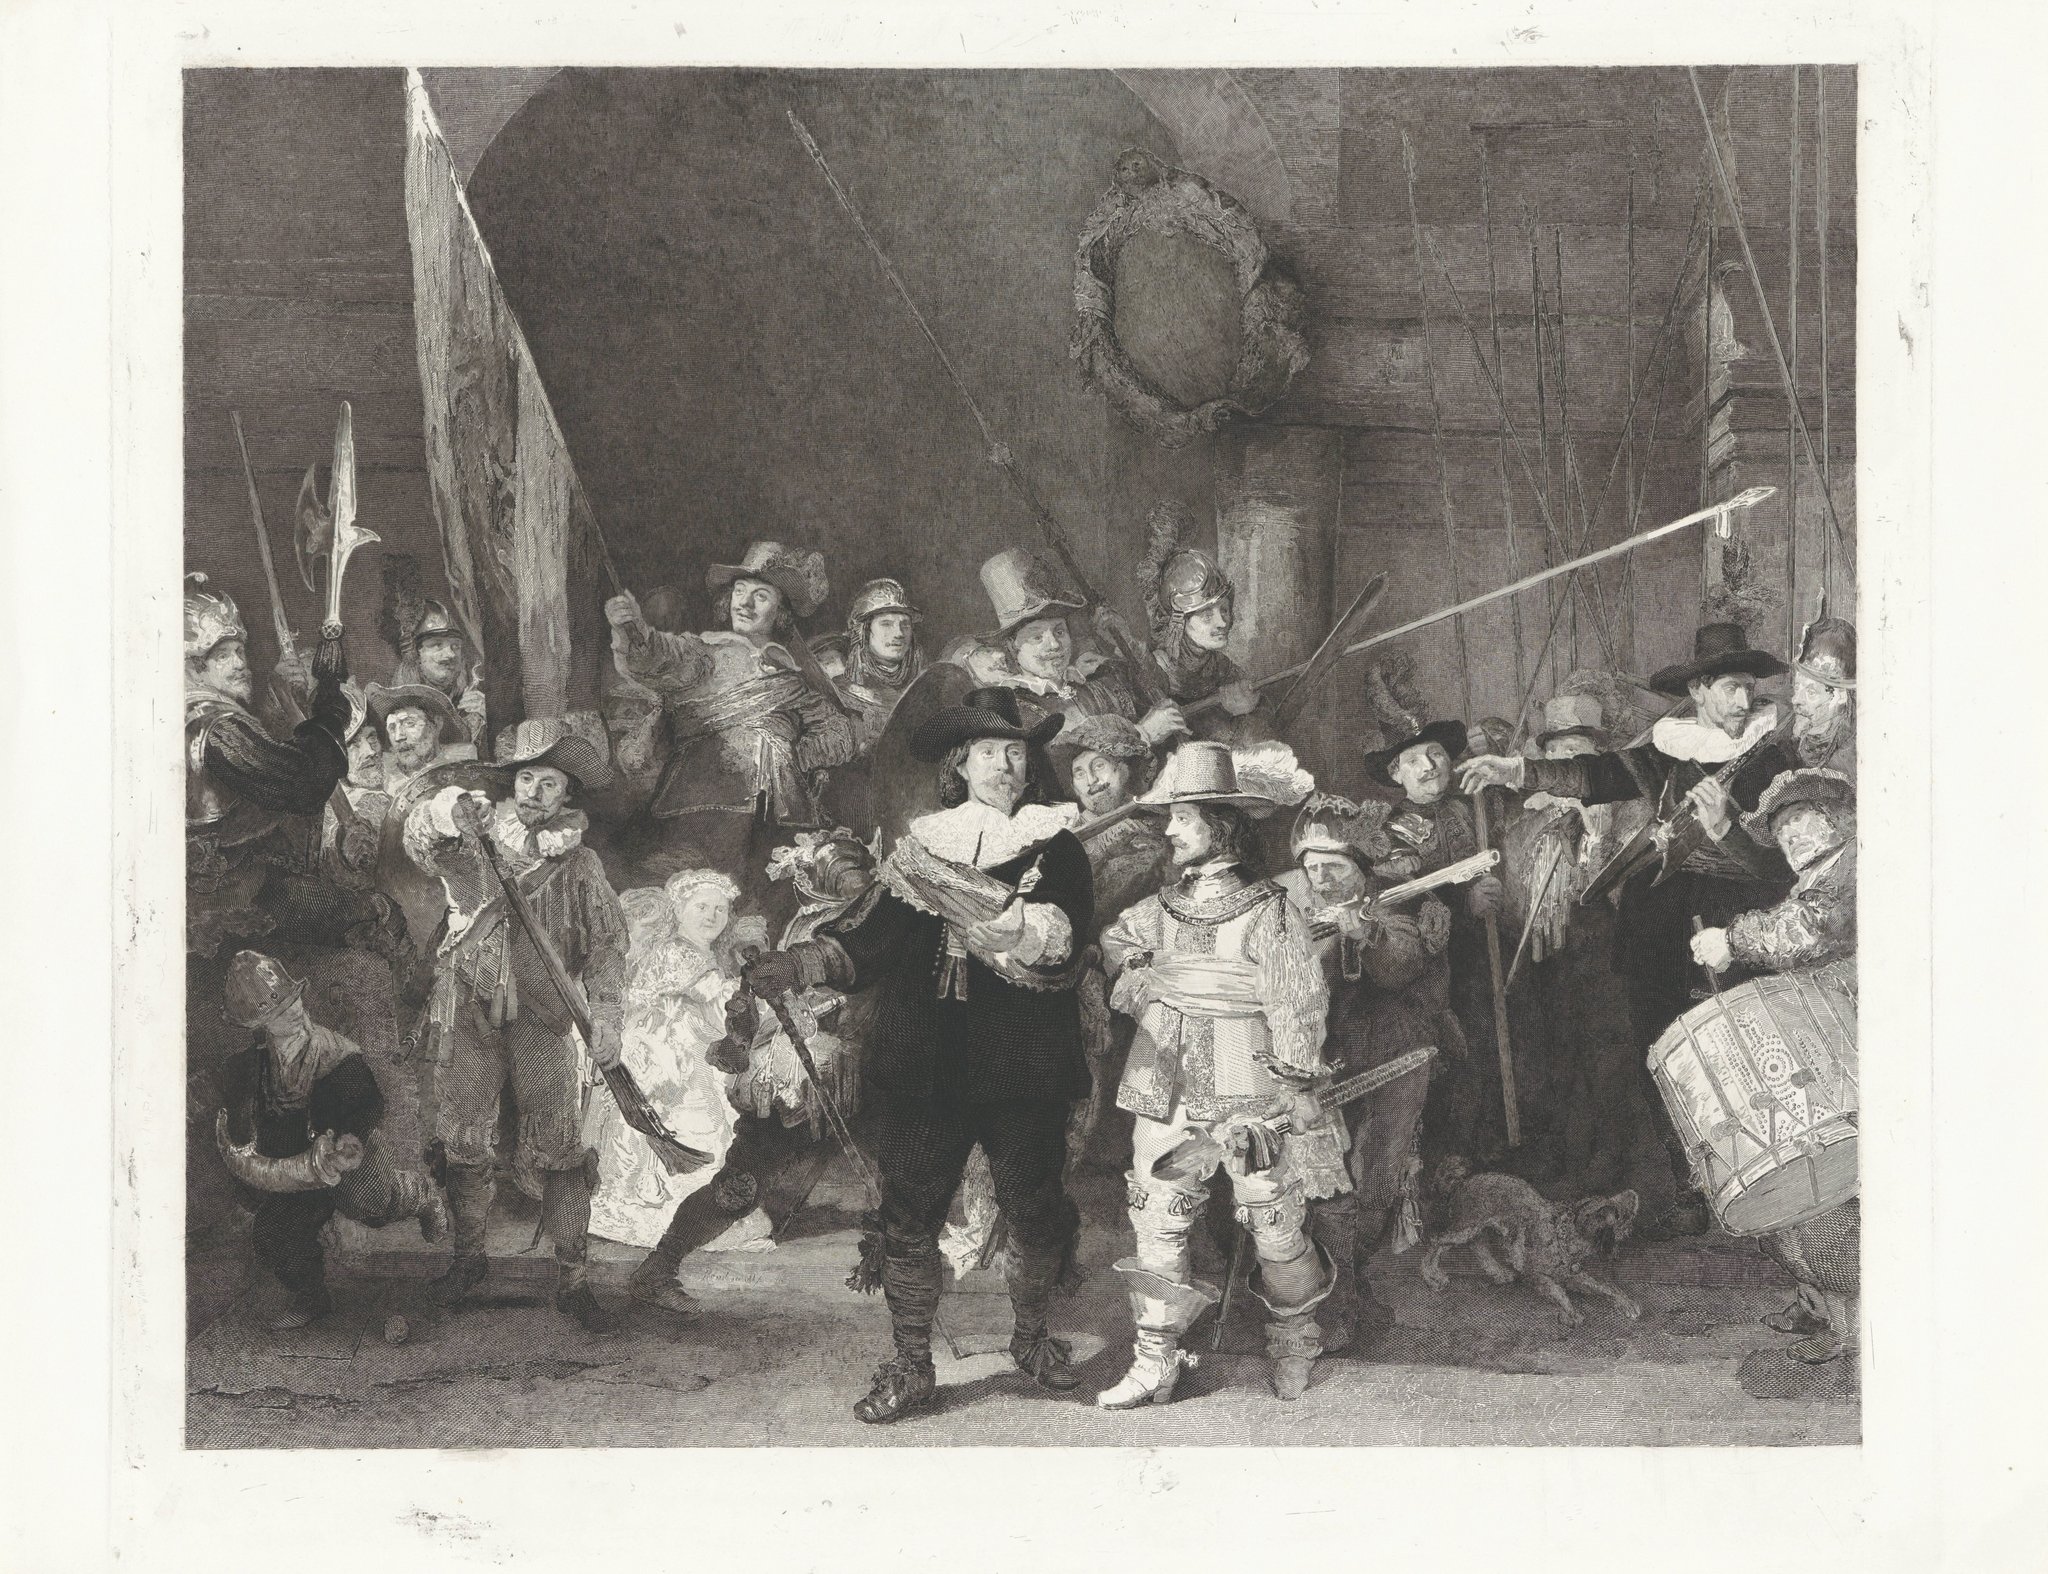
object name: print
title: Het korporaalschap van kapitein Frans Banninck Cocq en luitenant Willem van Ruytenburch, bekend als de 'Nachtwacht'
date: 1863-1864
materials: paper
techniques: drypoint, engraving, etching, roulette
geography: amsterdam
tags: proclamation of peace, celebration meal, feast, banquet, festivities on events of national importance, picture, painting, land forces (+ citizen soldiery, civil guard, citizen militia), historical events and situations, dog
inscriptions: collector's mark: Lugt 2228